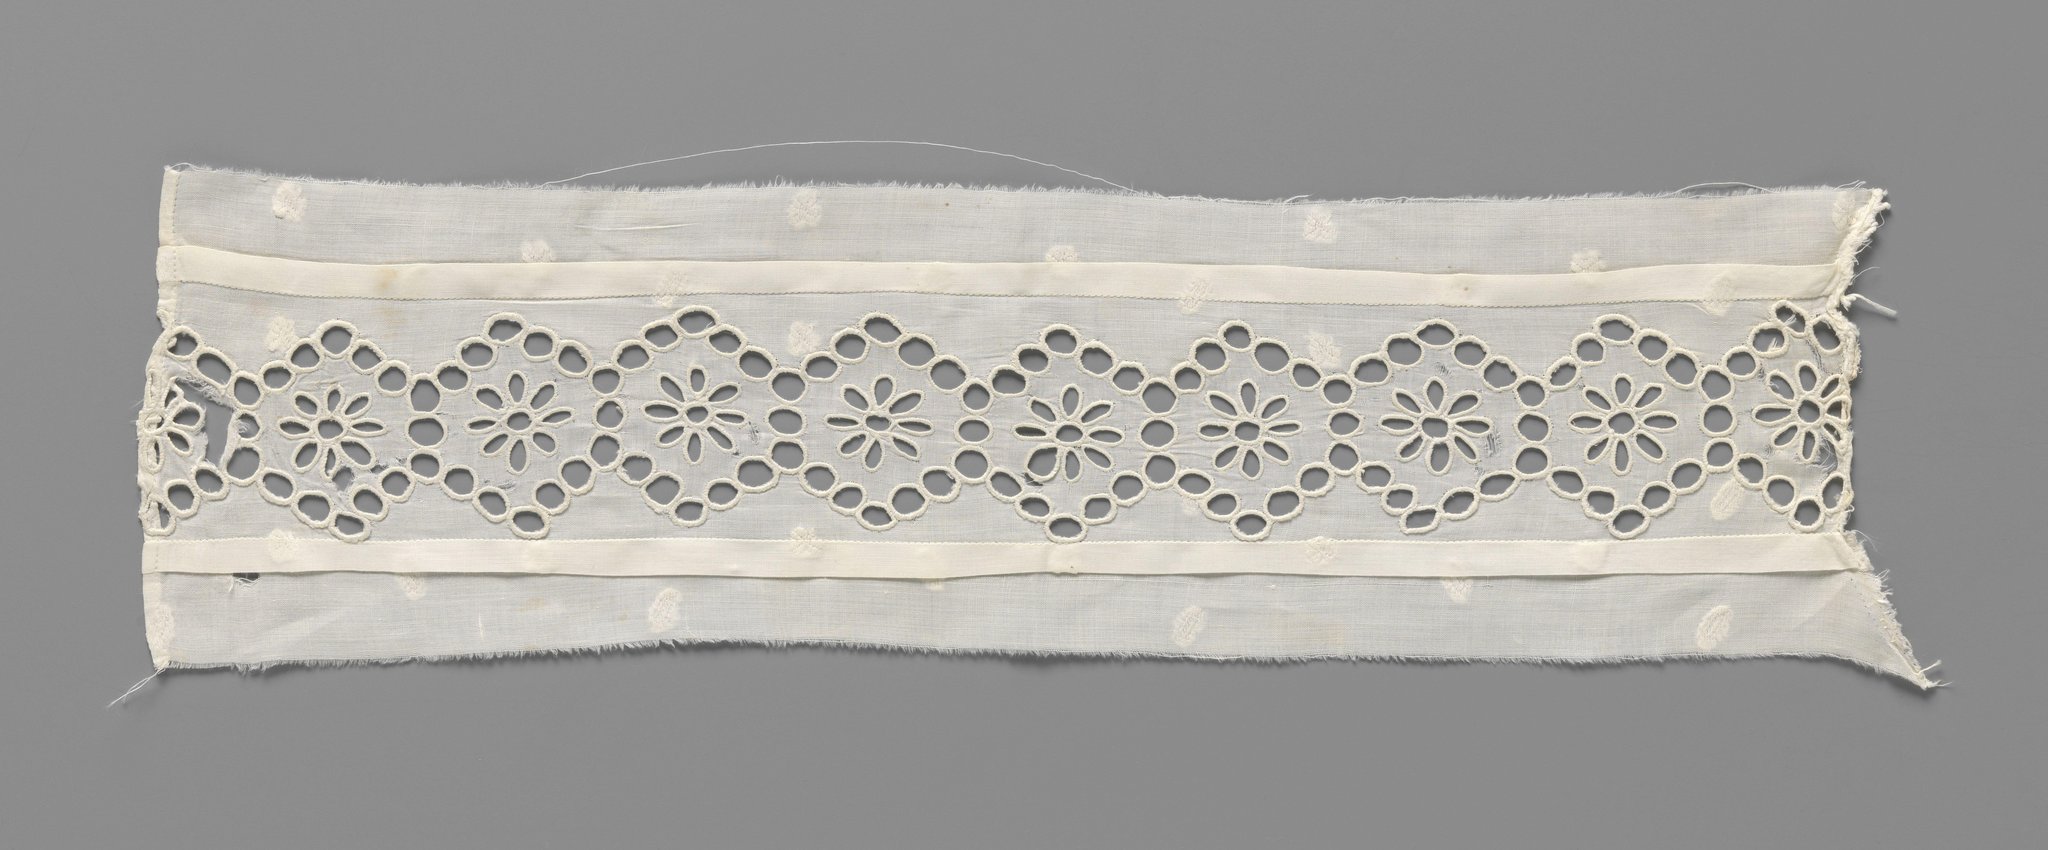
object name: strip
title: Strook batist met kantborduurwerk afkomstig van een blouse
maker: c.i. bosch reitz-teding van berkhout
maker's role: kantwerkster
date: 1870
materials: textile, cotton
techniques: weave, embroidery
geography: amsterdam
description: Strook naturelkleurig batist met kantborduurwerk: Engels borduurwerk. Het patroon bestaat uit een rij aaneengesloten en opengewerkte cirkels met in elke cirkel een opengewerkte margriet. Op het batist staat een strooipatroon van geborduurde blaadjes. De strook is uit een blouse geknipt.